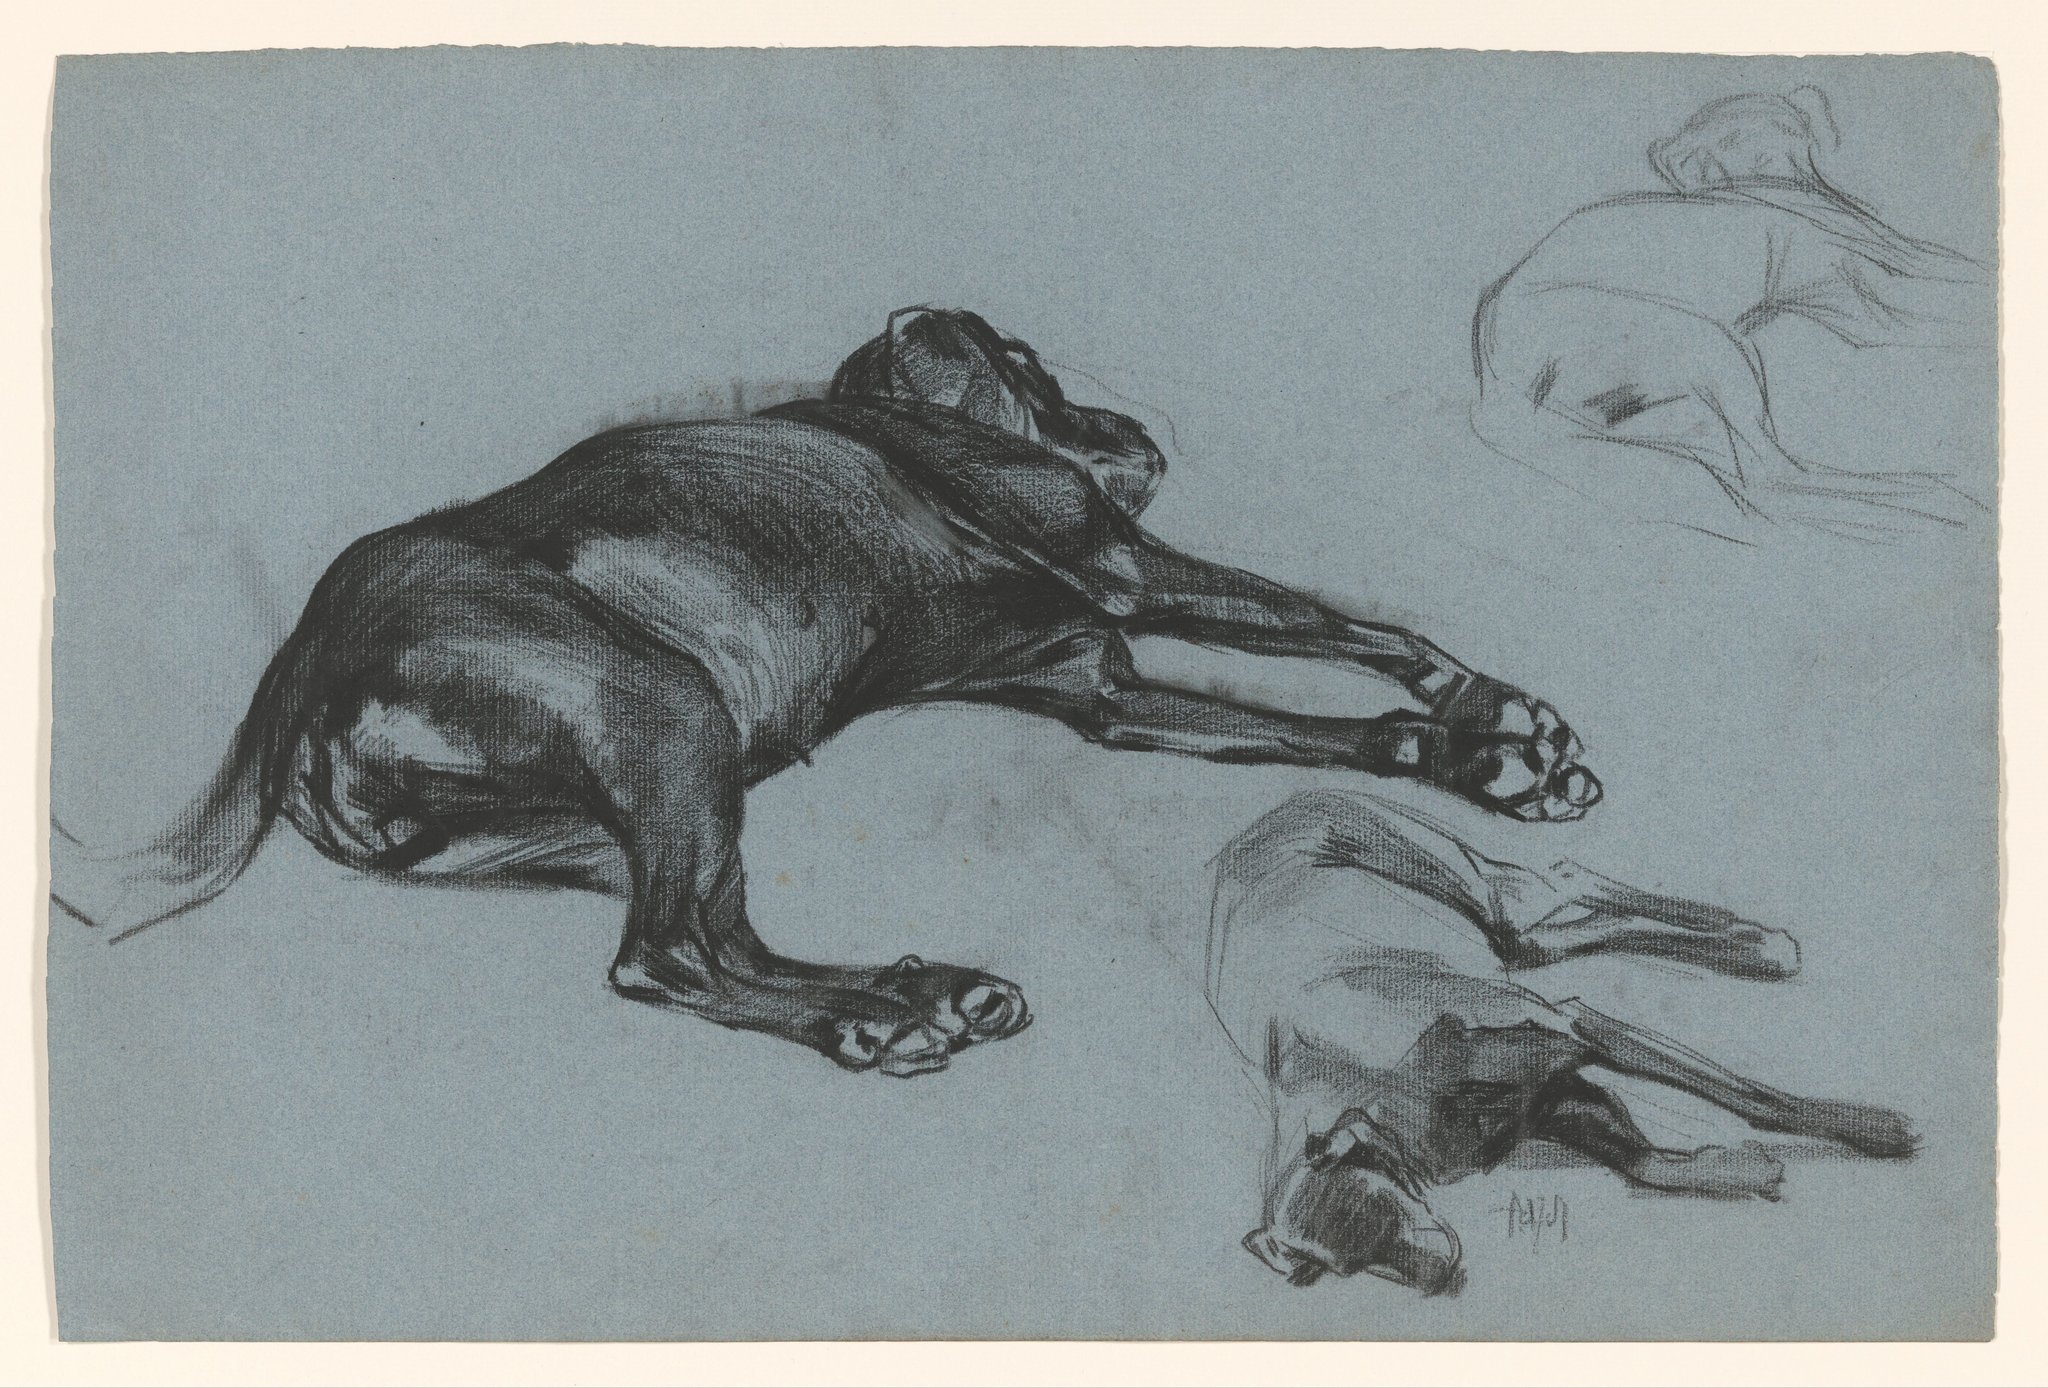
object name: drawing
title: Liggende honden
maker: pieter de josselin de jong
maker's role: draughtsman, painter, print maker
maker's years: 1861-1906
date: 1871-1906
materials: chalk, paper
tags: dog